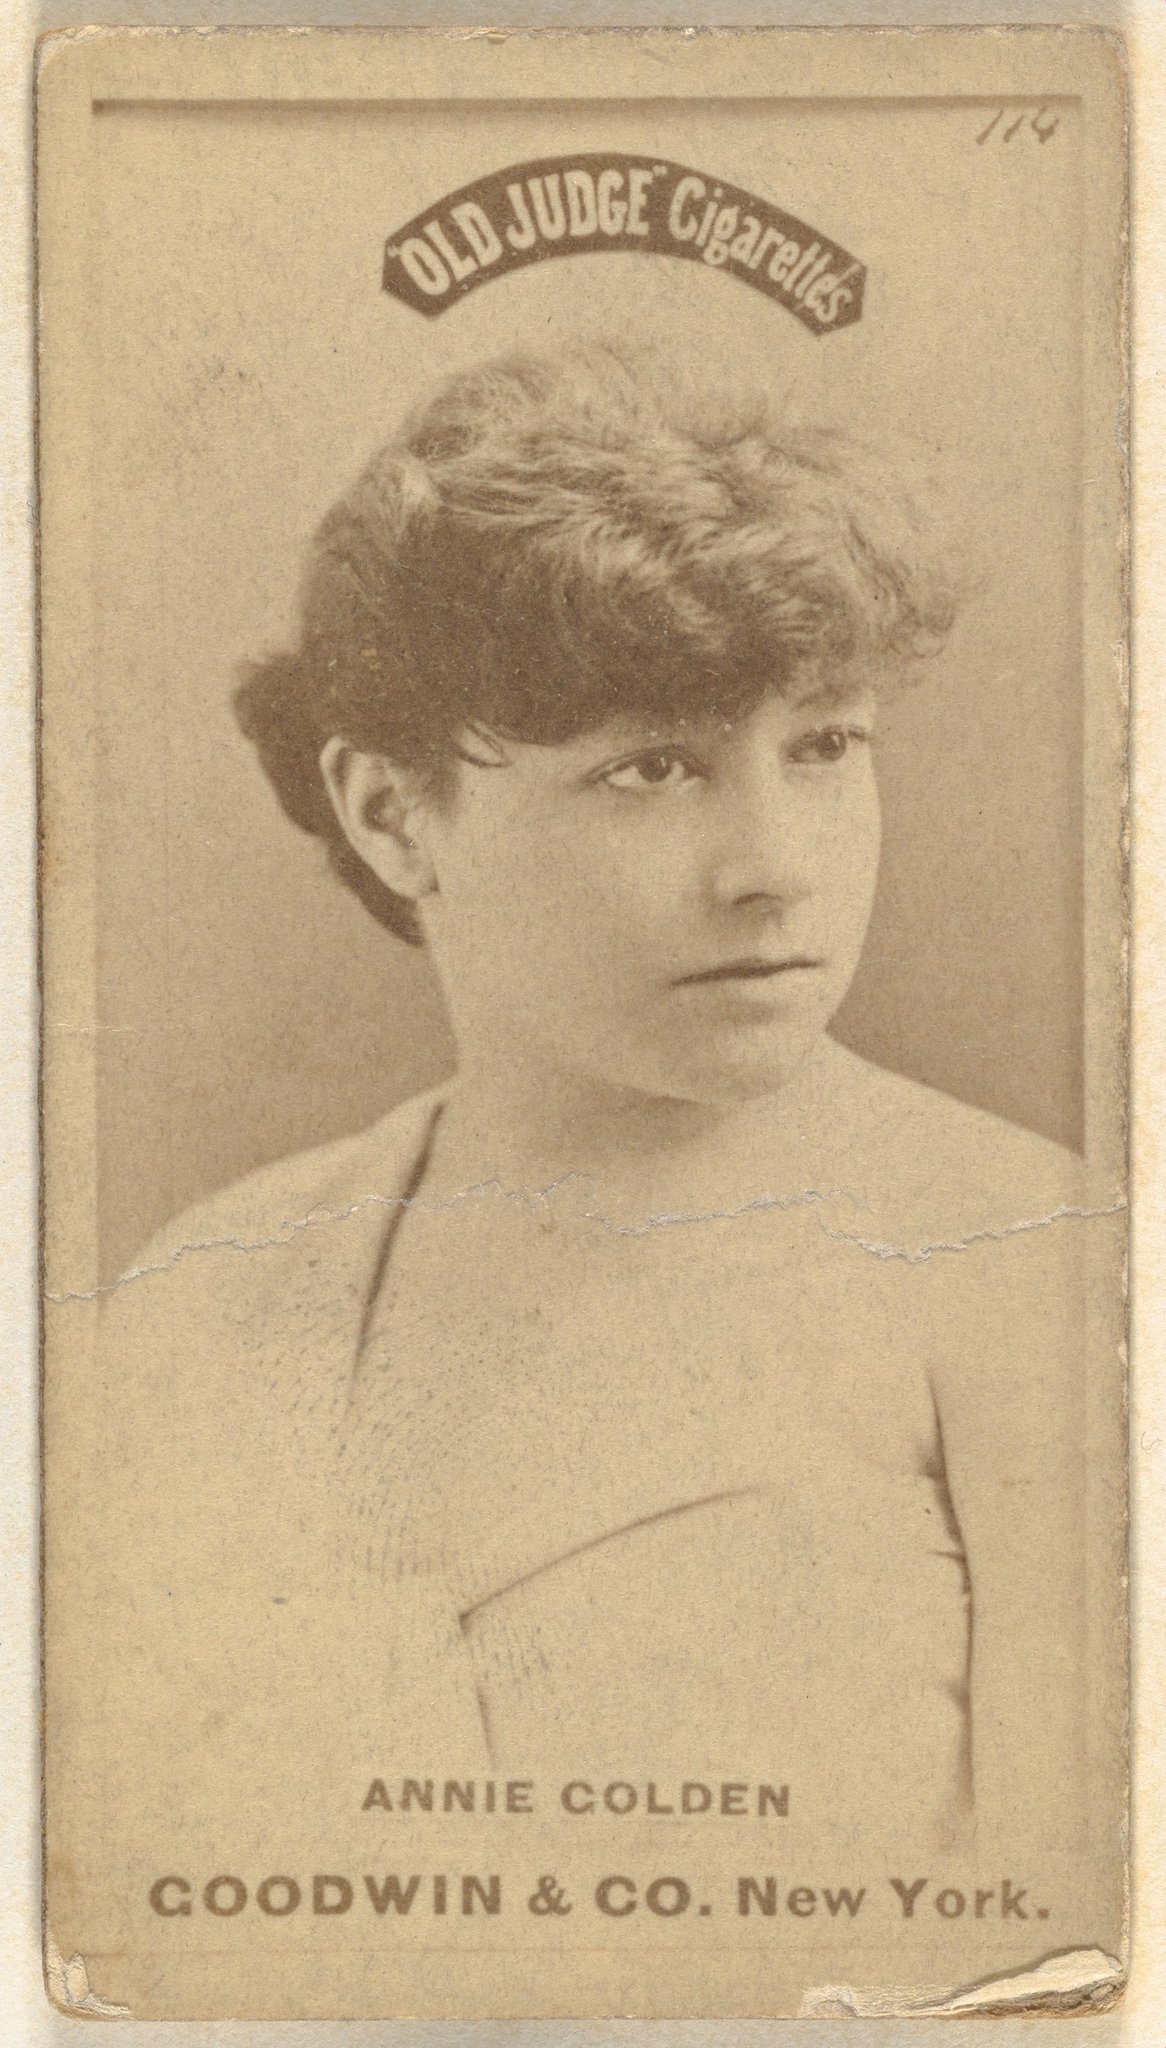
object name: photograph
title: Annie Golden, from the Actors and Actresses series (N171) for Old Judge Cigarettes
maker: goodwin & company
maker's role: publisher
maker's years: 1850-1950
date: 1886-1890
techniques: albumen silver print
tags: portraits,women,actresses